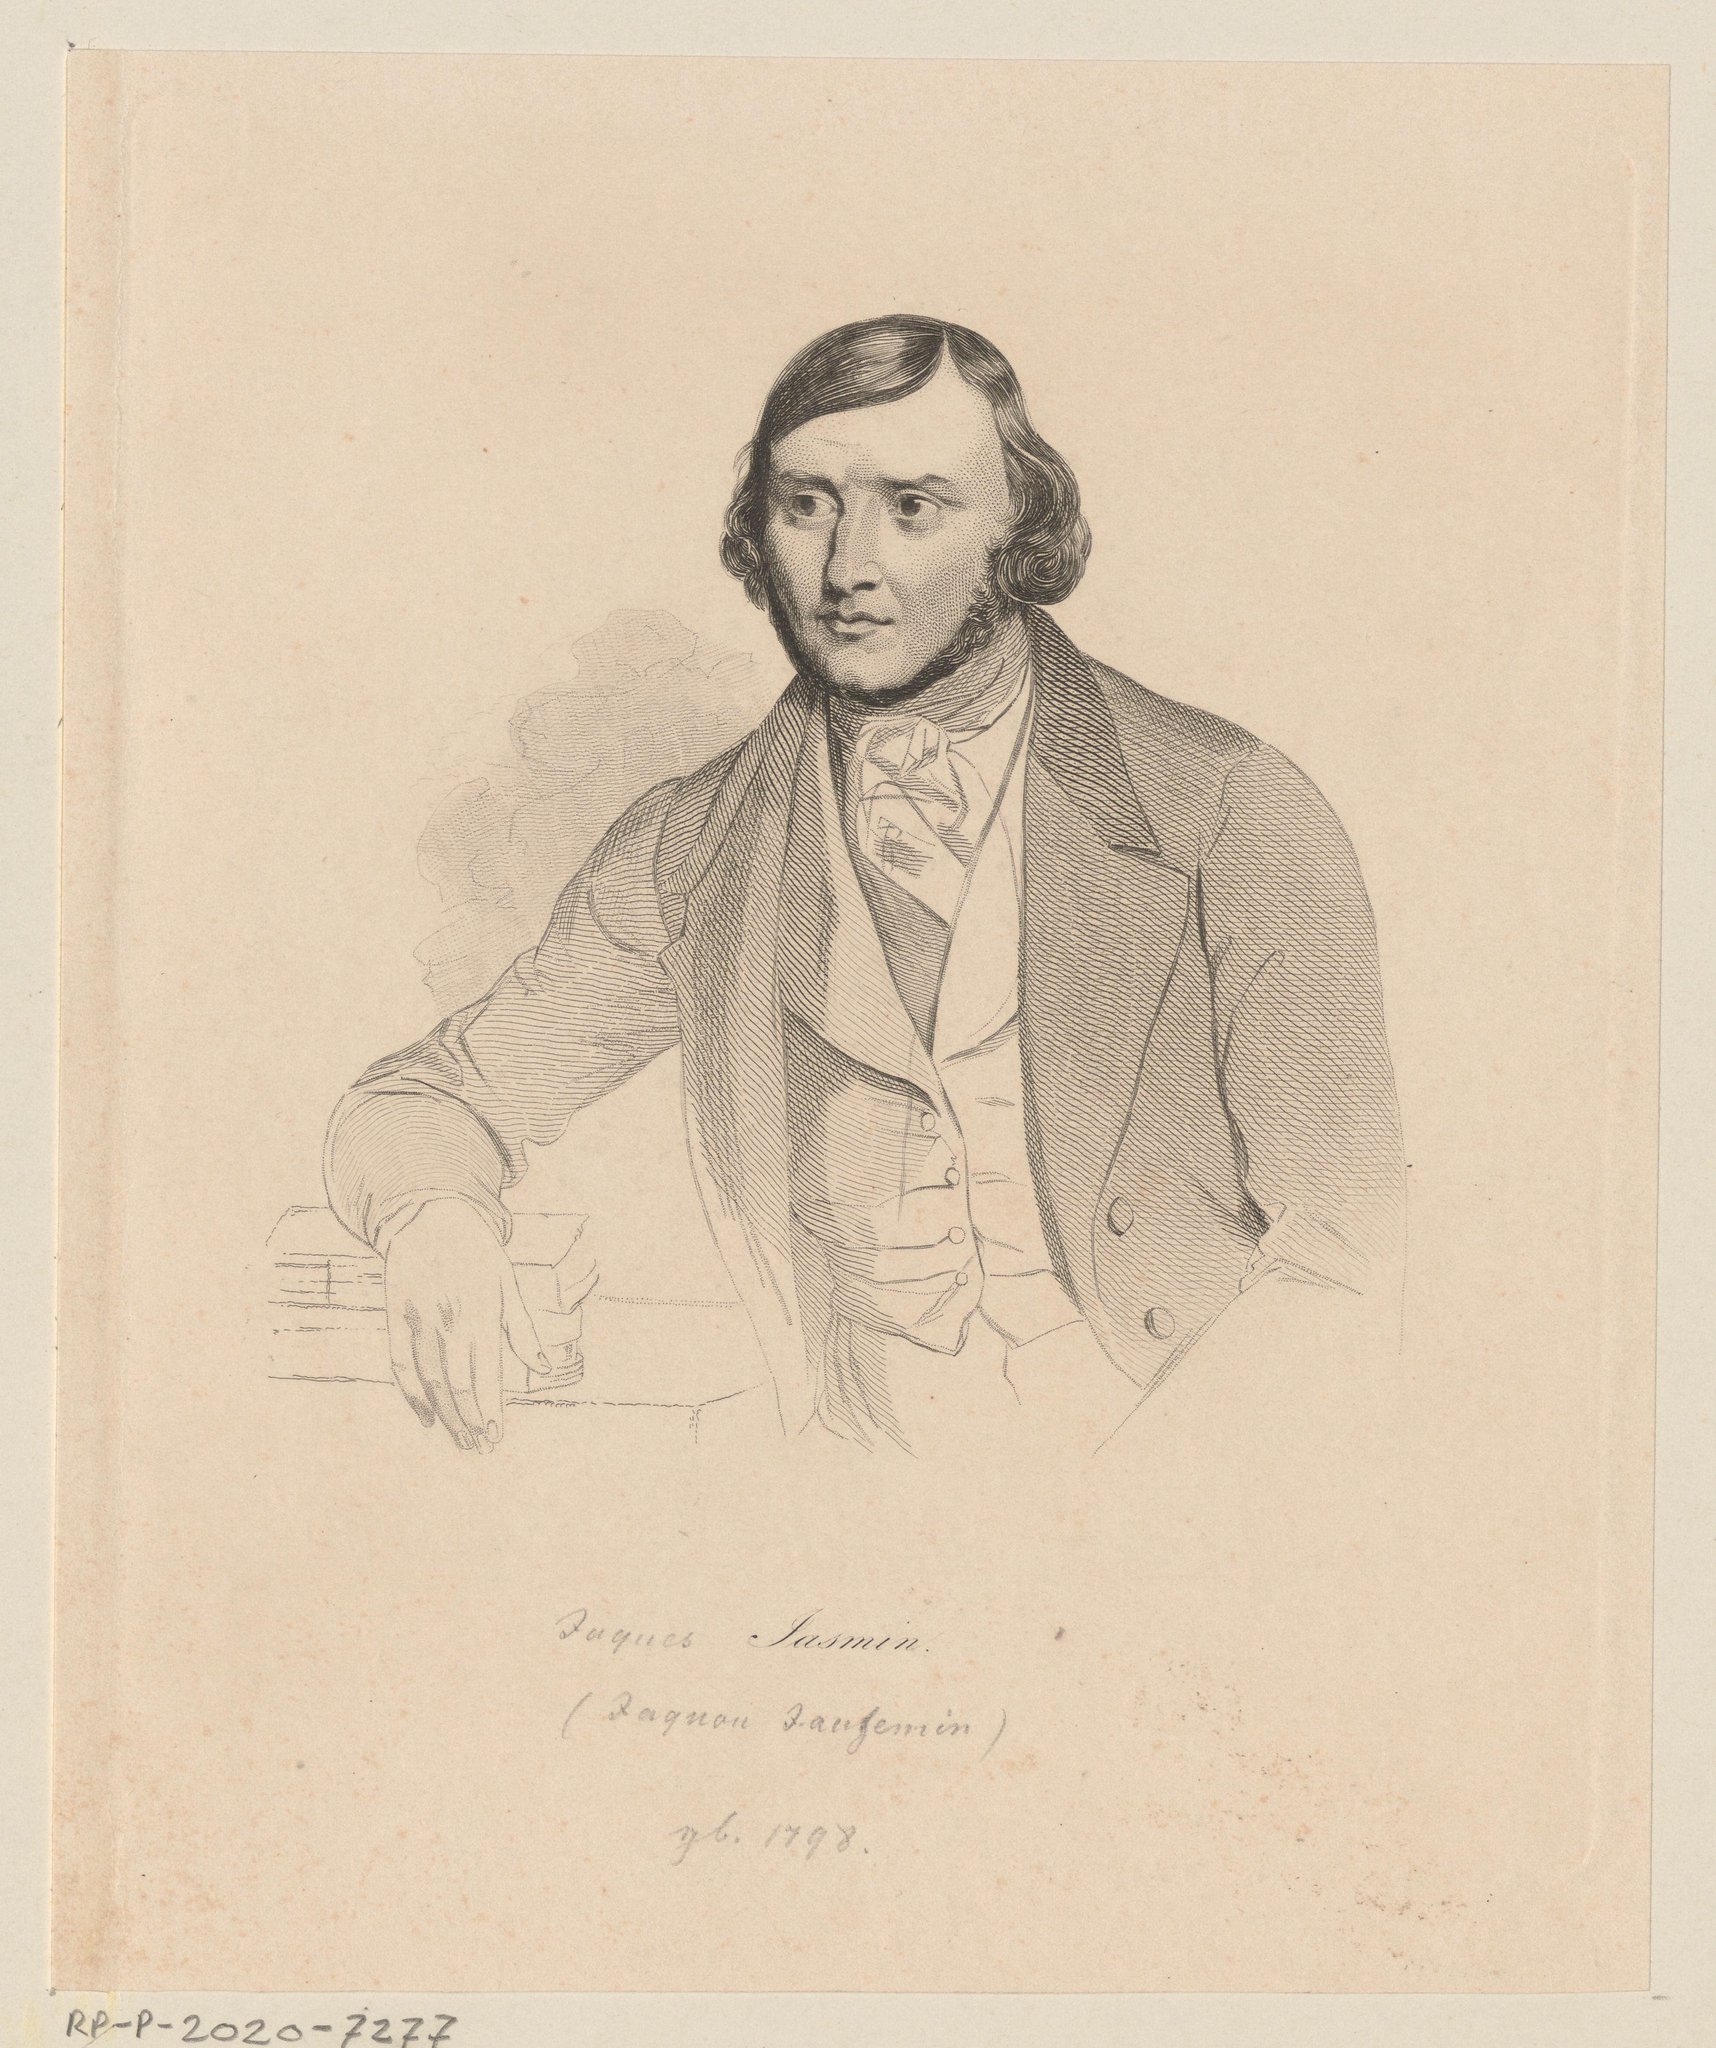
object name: print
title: Portret van Jasmin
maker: Anonymous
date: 1825-1850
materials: paper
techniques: etching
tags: historical persons, writer, poet, author